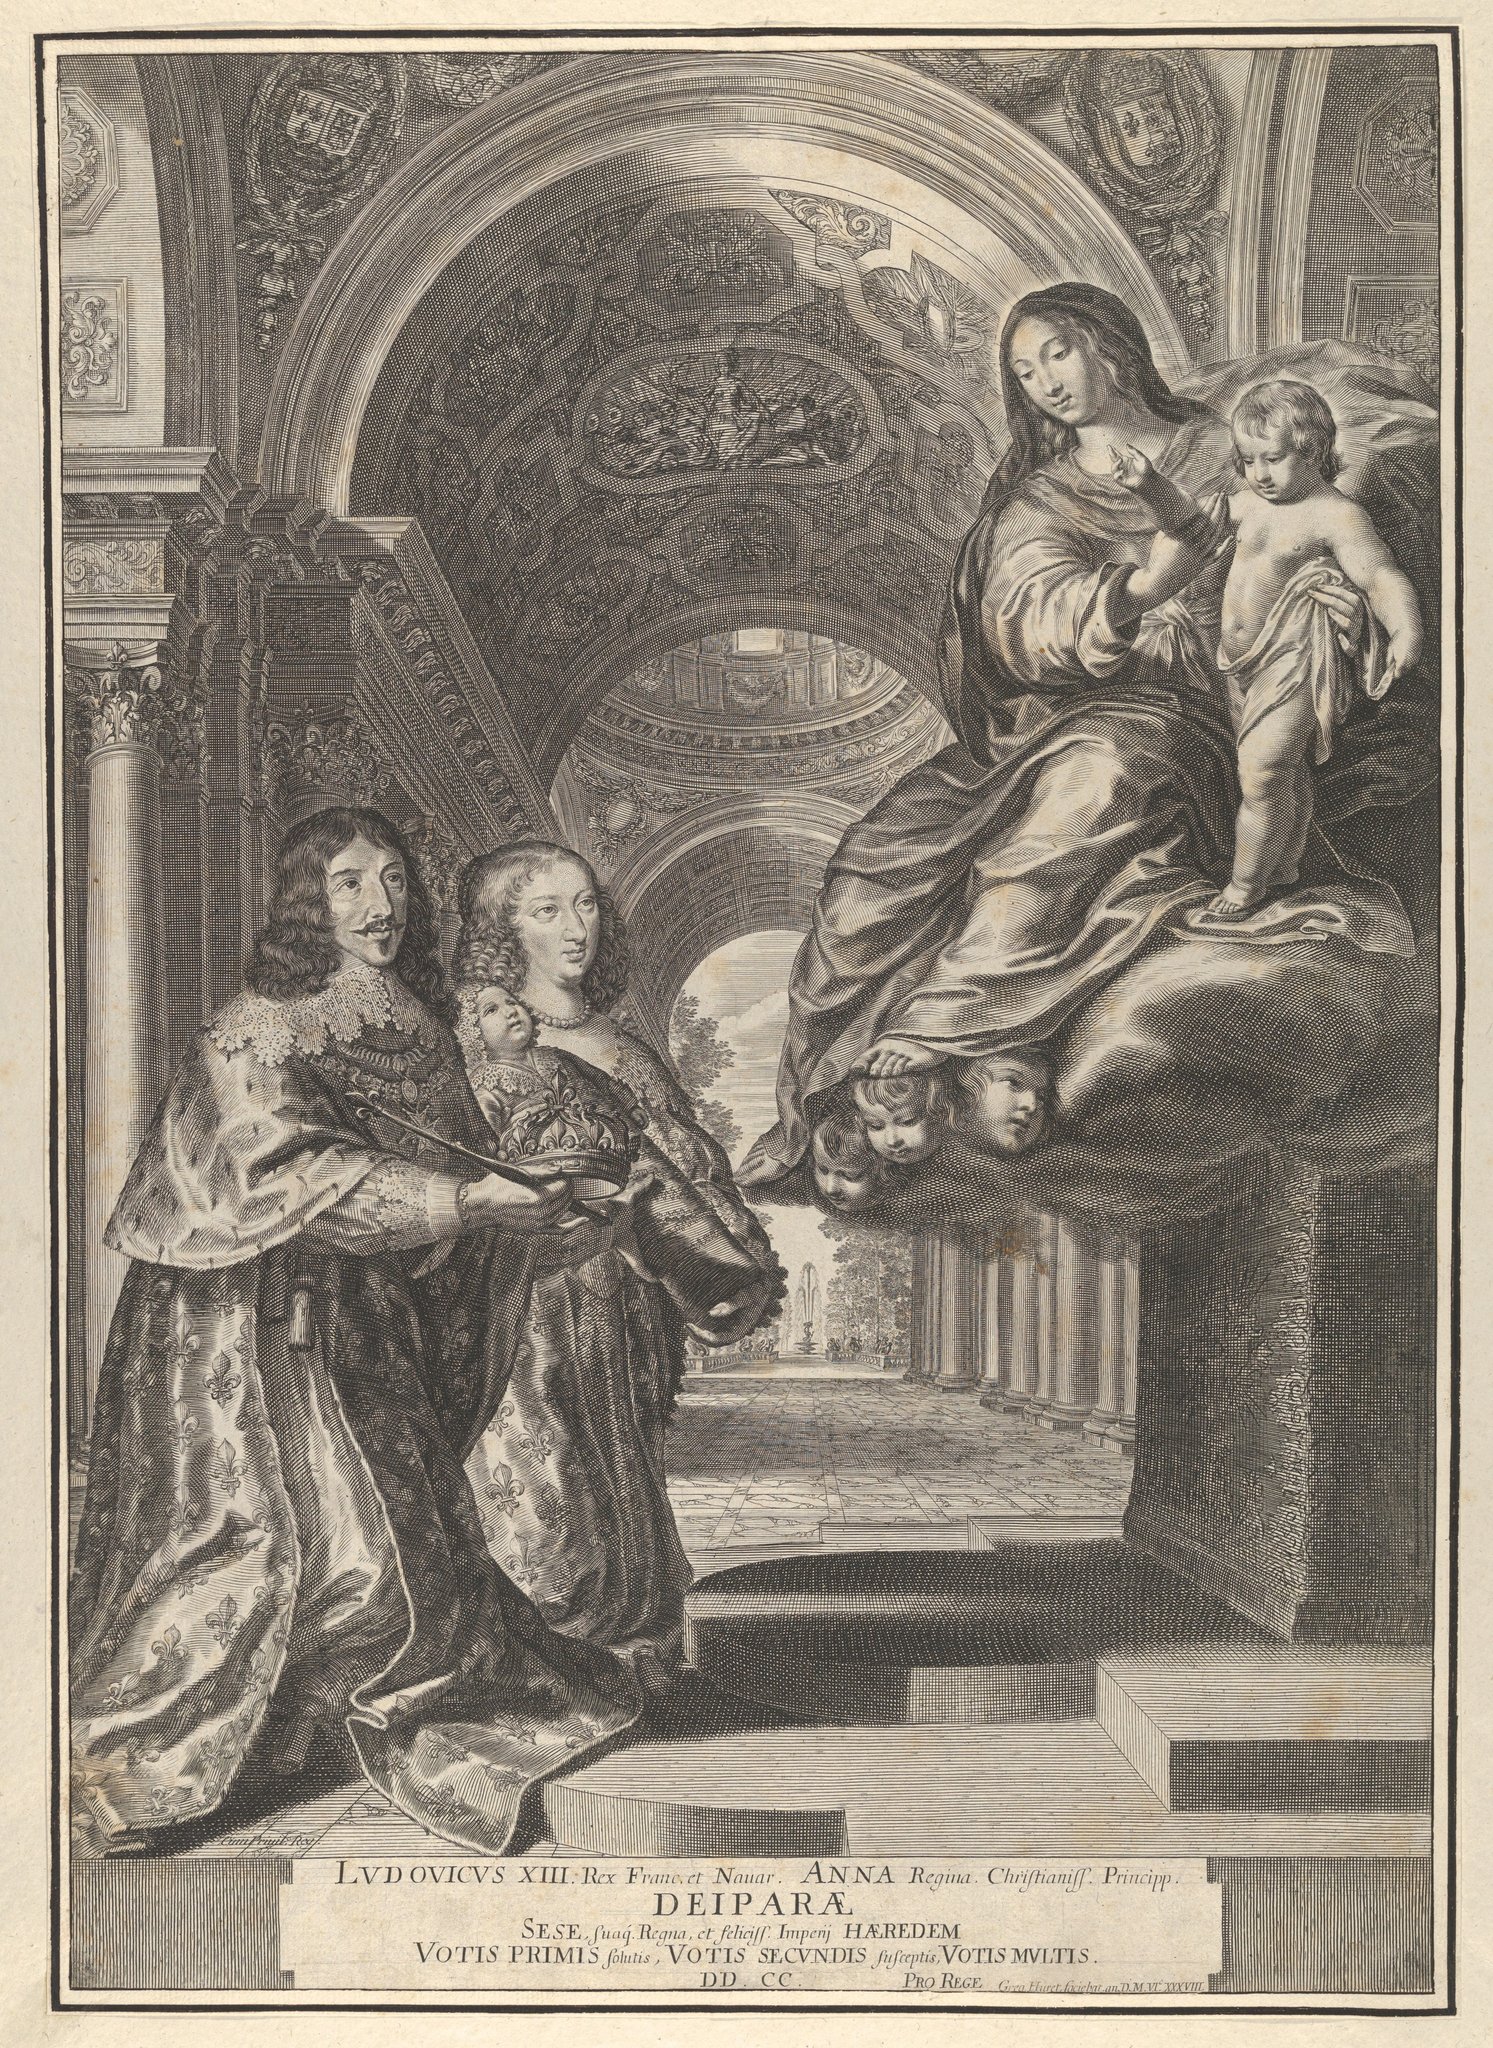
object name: print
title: Louis XIII and Anne of Austria Presenting the Dauphin to the Virgin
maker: grégoire huret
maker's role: artist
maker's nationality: french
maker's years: 1606-1670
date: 1638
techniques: engraving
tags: kings,queens,madonna and child